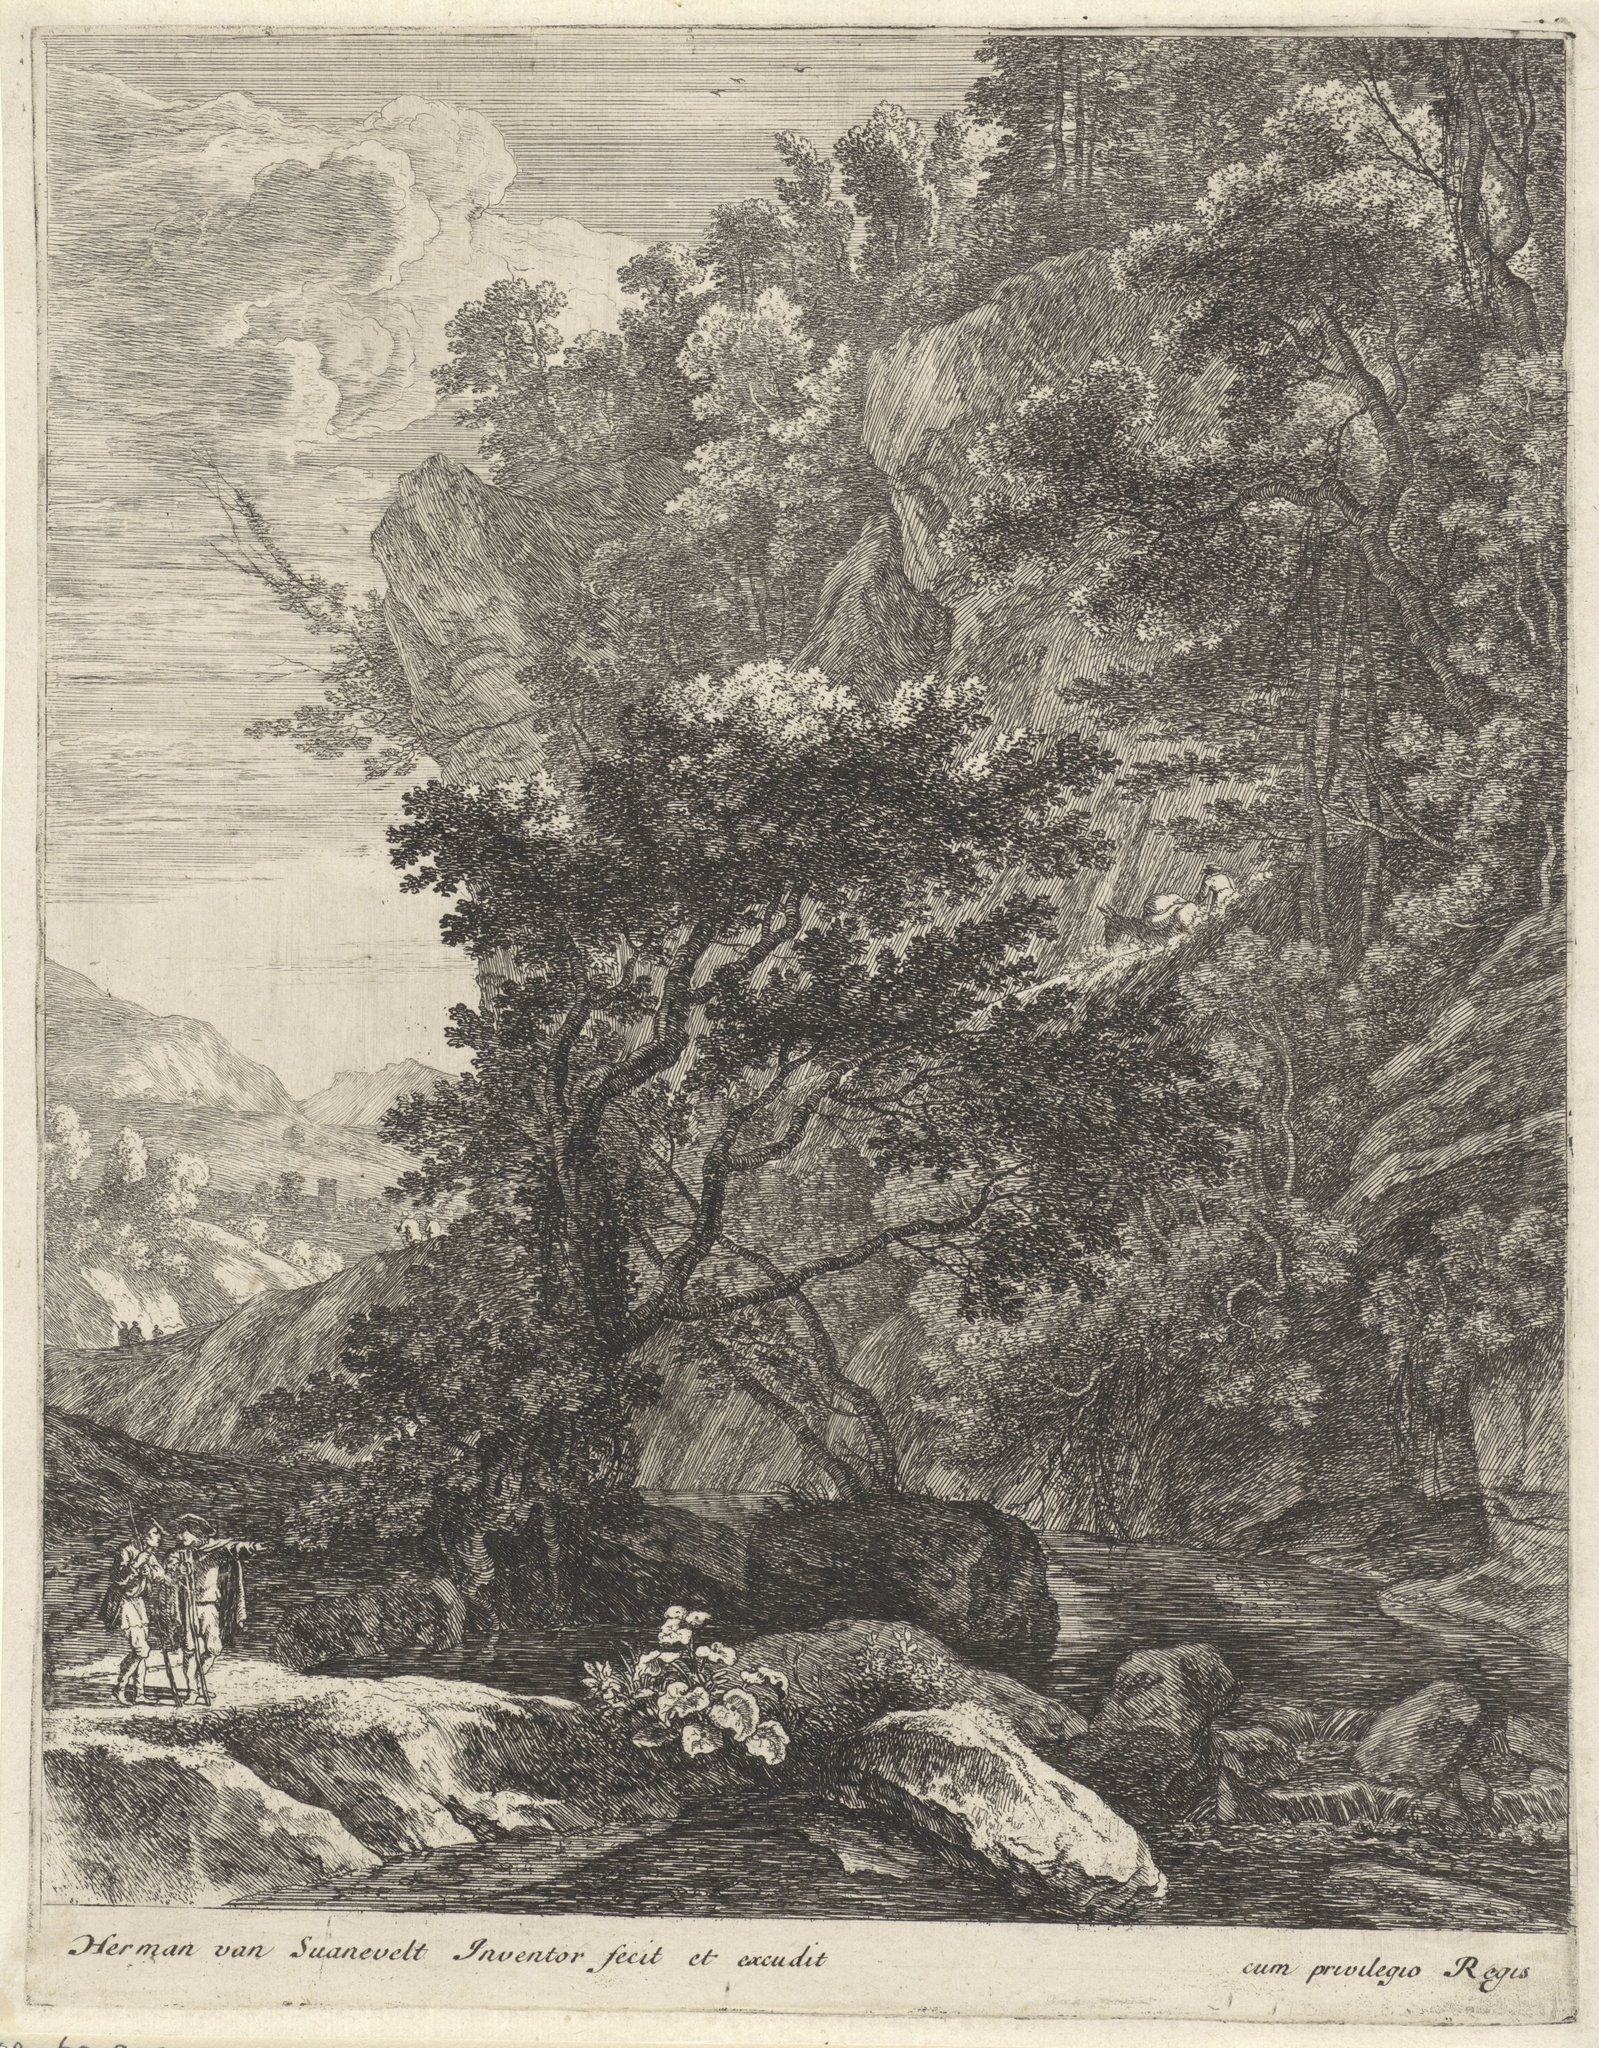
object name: print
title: Berglandschap met rivier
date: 1650-1655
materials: paper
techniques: etching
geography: paris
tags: river, 'en route', traveller under way, mountains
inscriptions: collector's mark: Lugt 240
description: Berglandschap met een pad langs een rivier. Op het pad staan twee figuren.